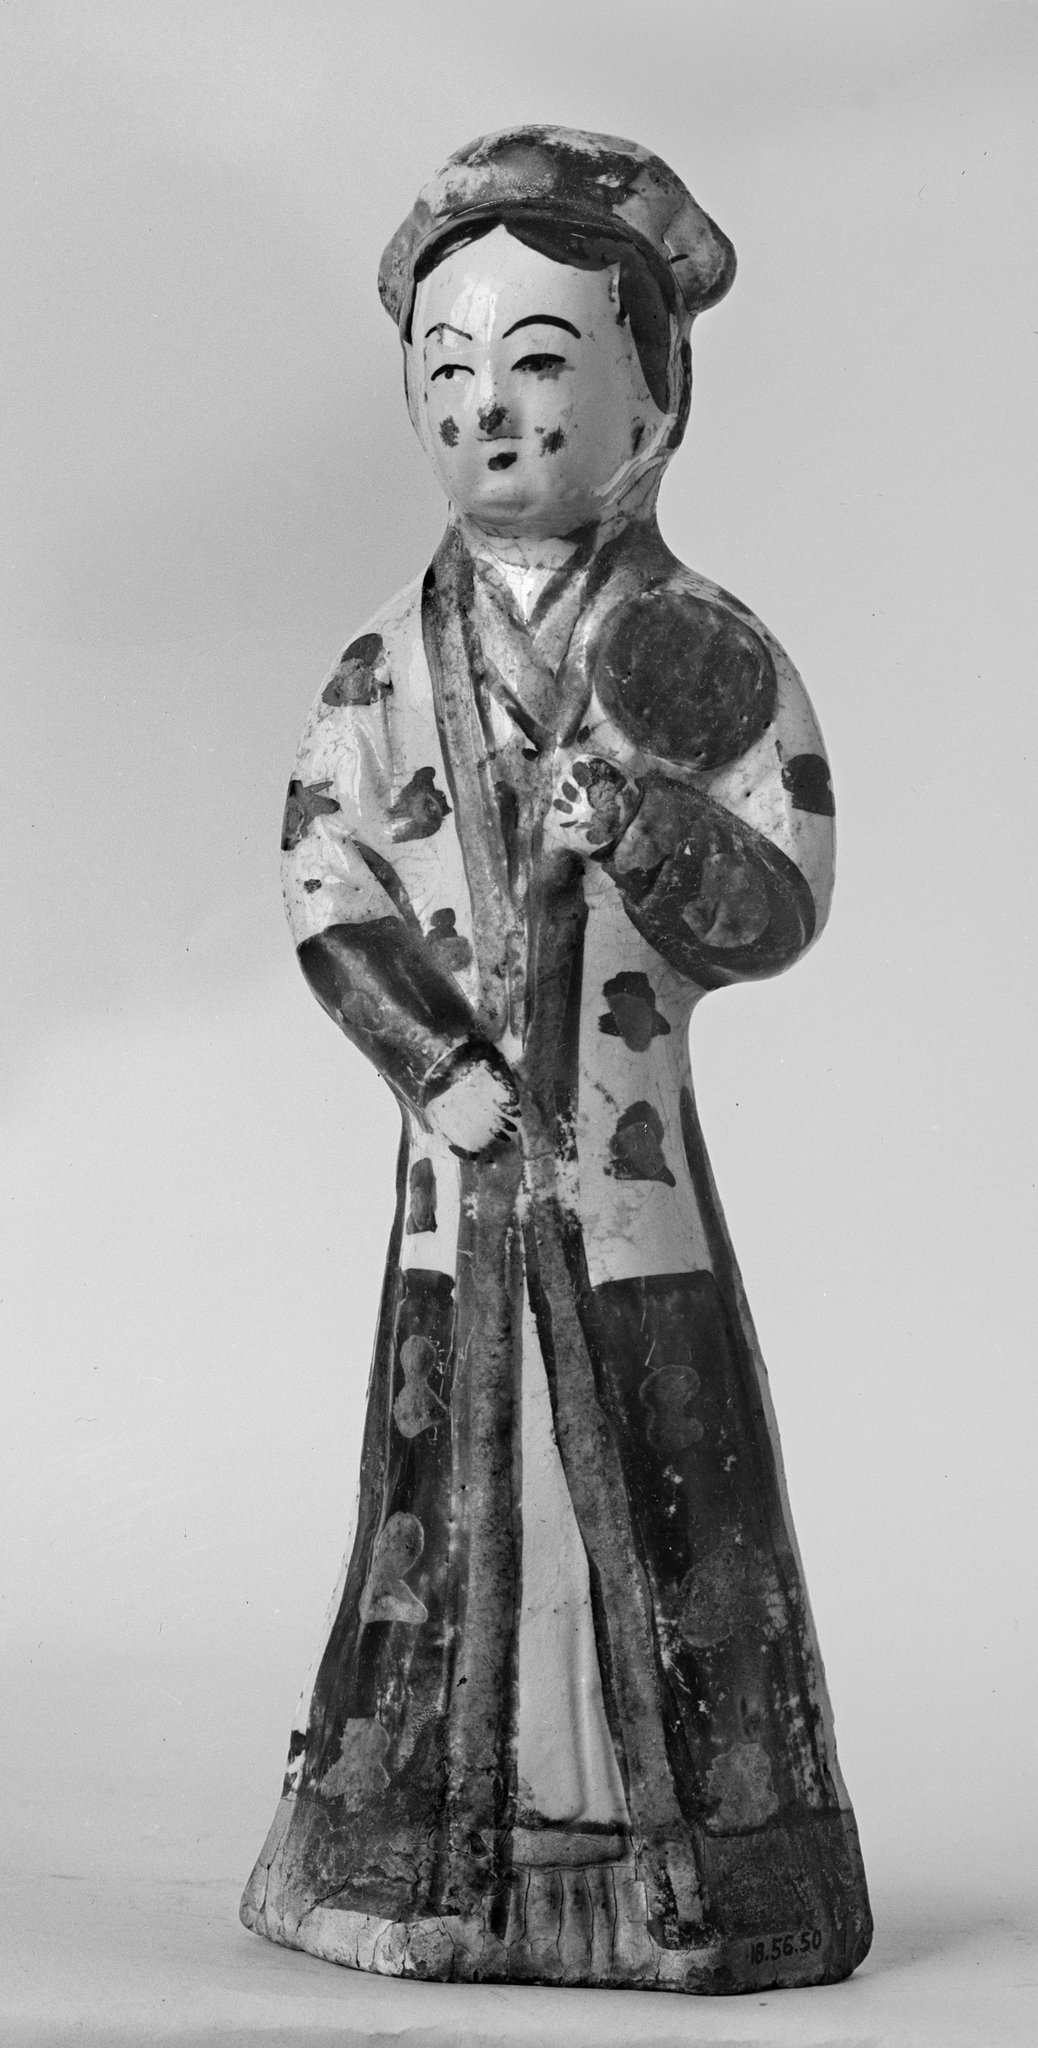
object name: figure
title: Figure of a standing lady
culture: chinese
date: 1101-1300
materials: enamel, stoneware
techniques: polychrome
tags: women